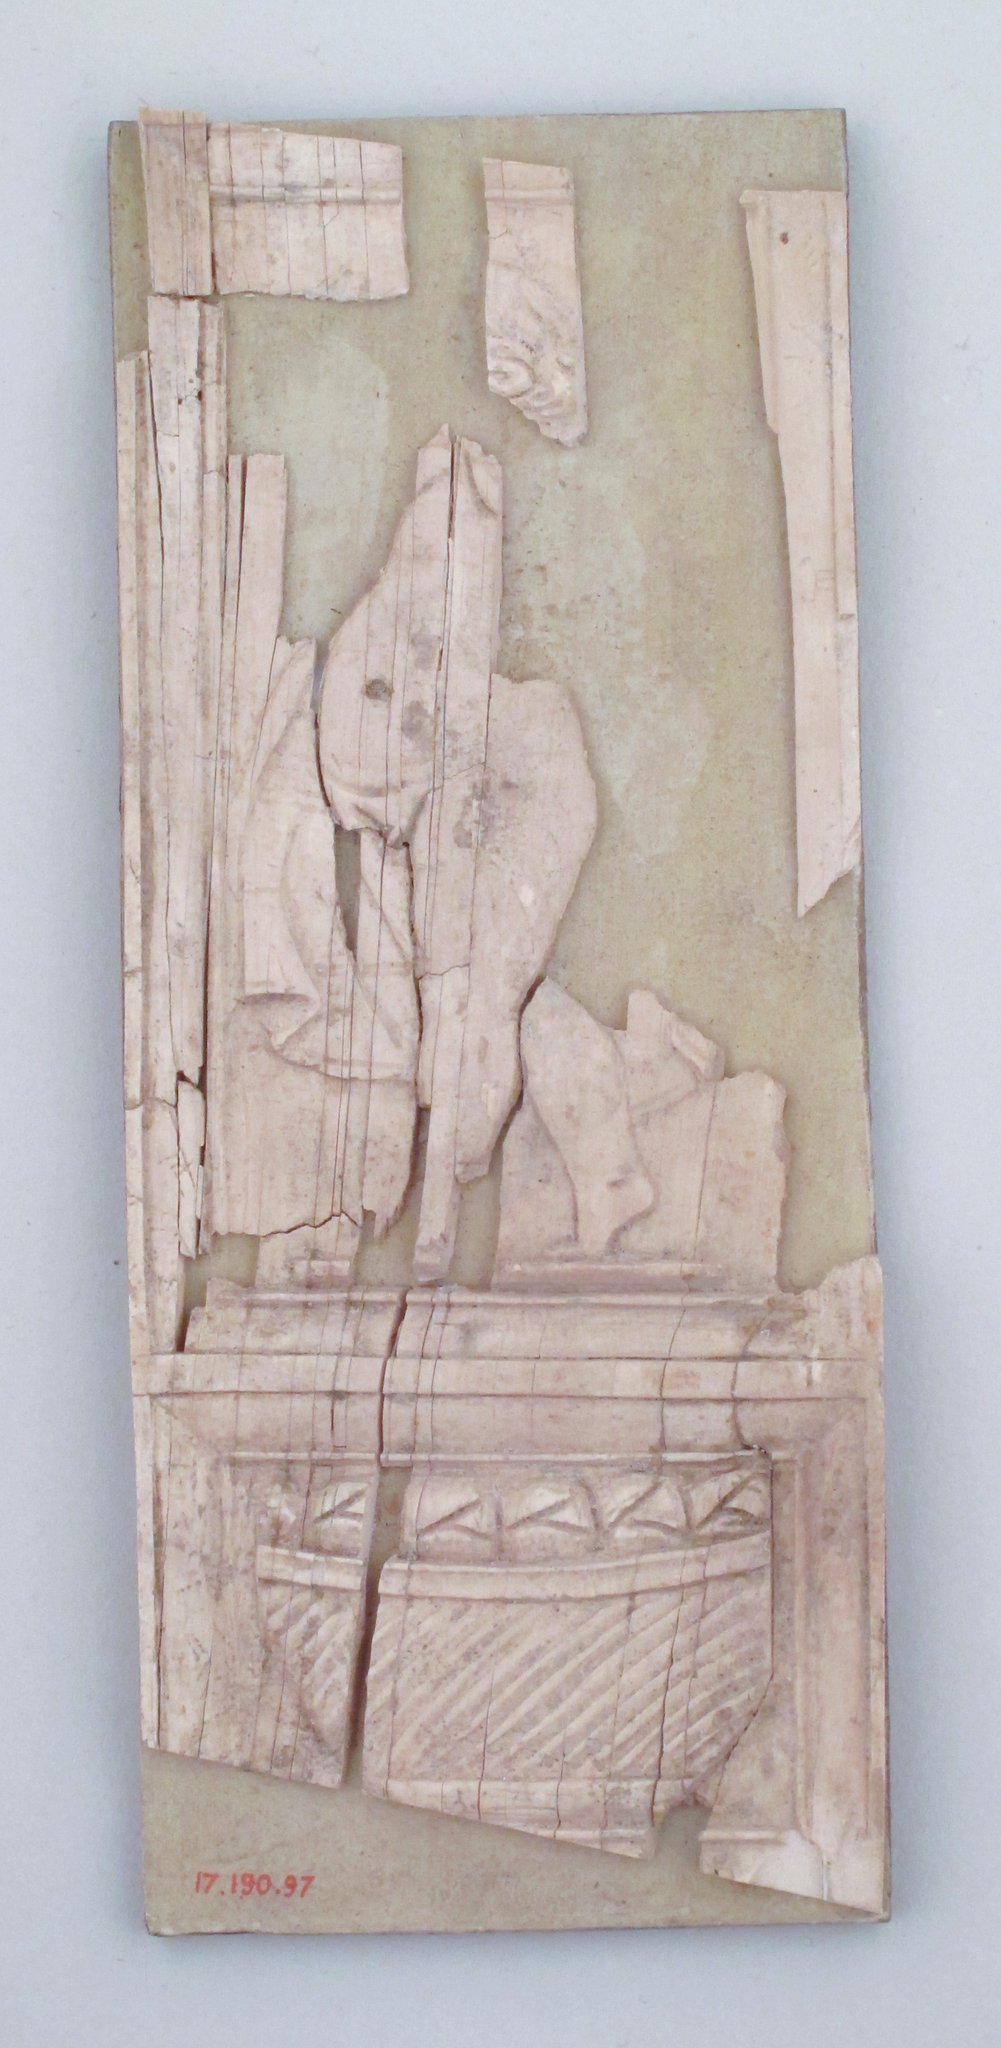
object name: relief from casket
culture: roman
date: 670 BCE-330 CE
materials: ivory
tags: eros